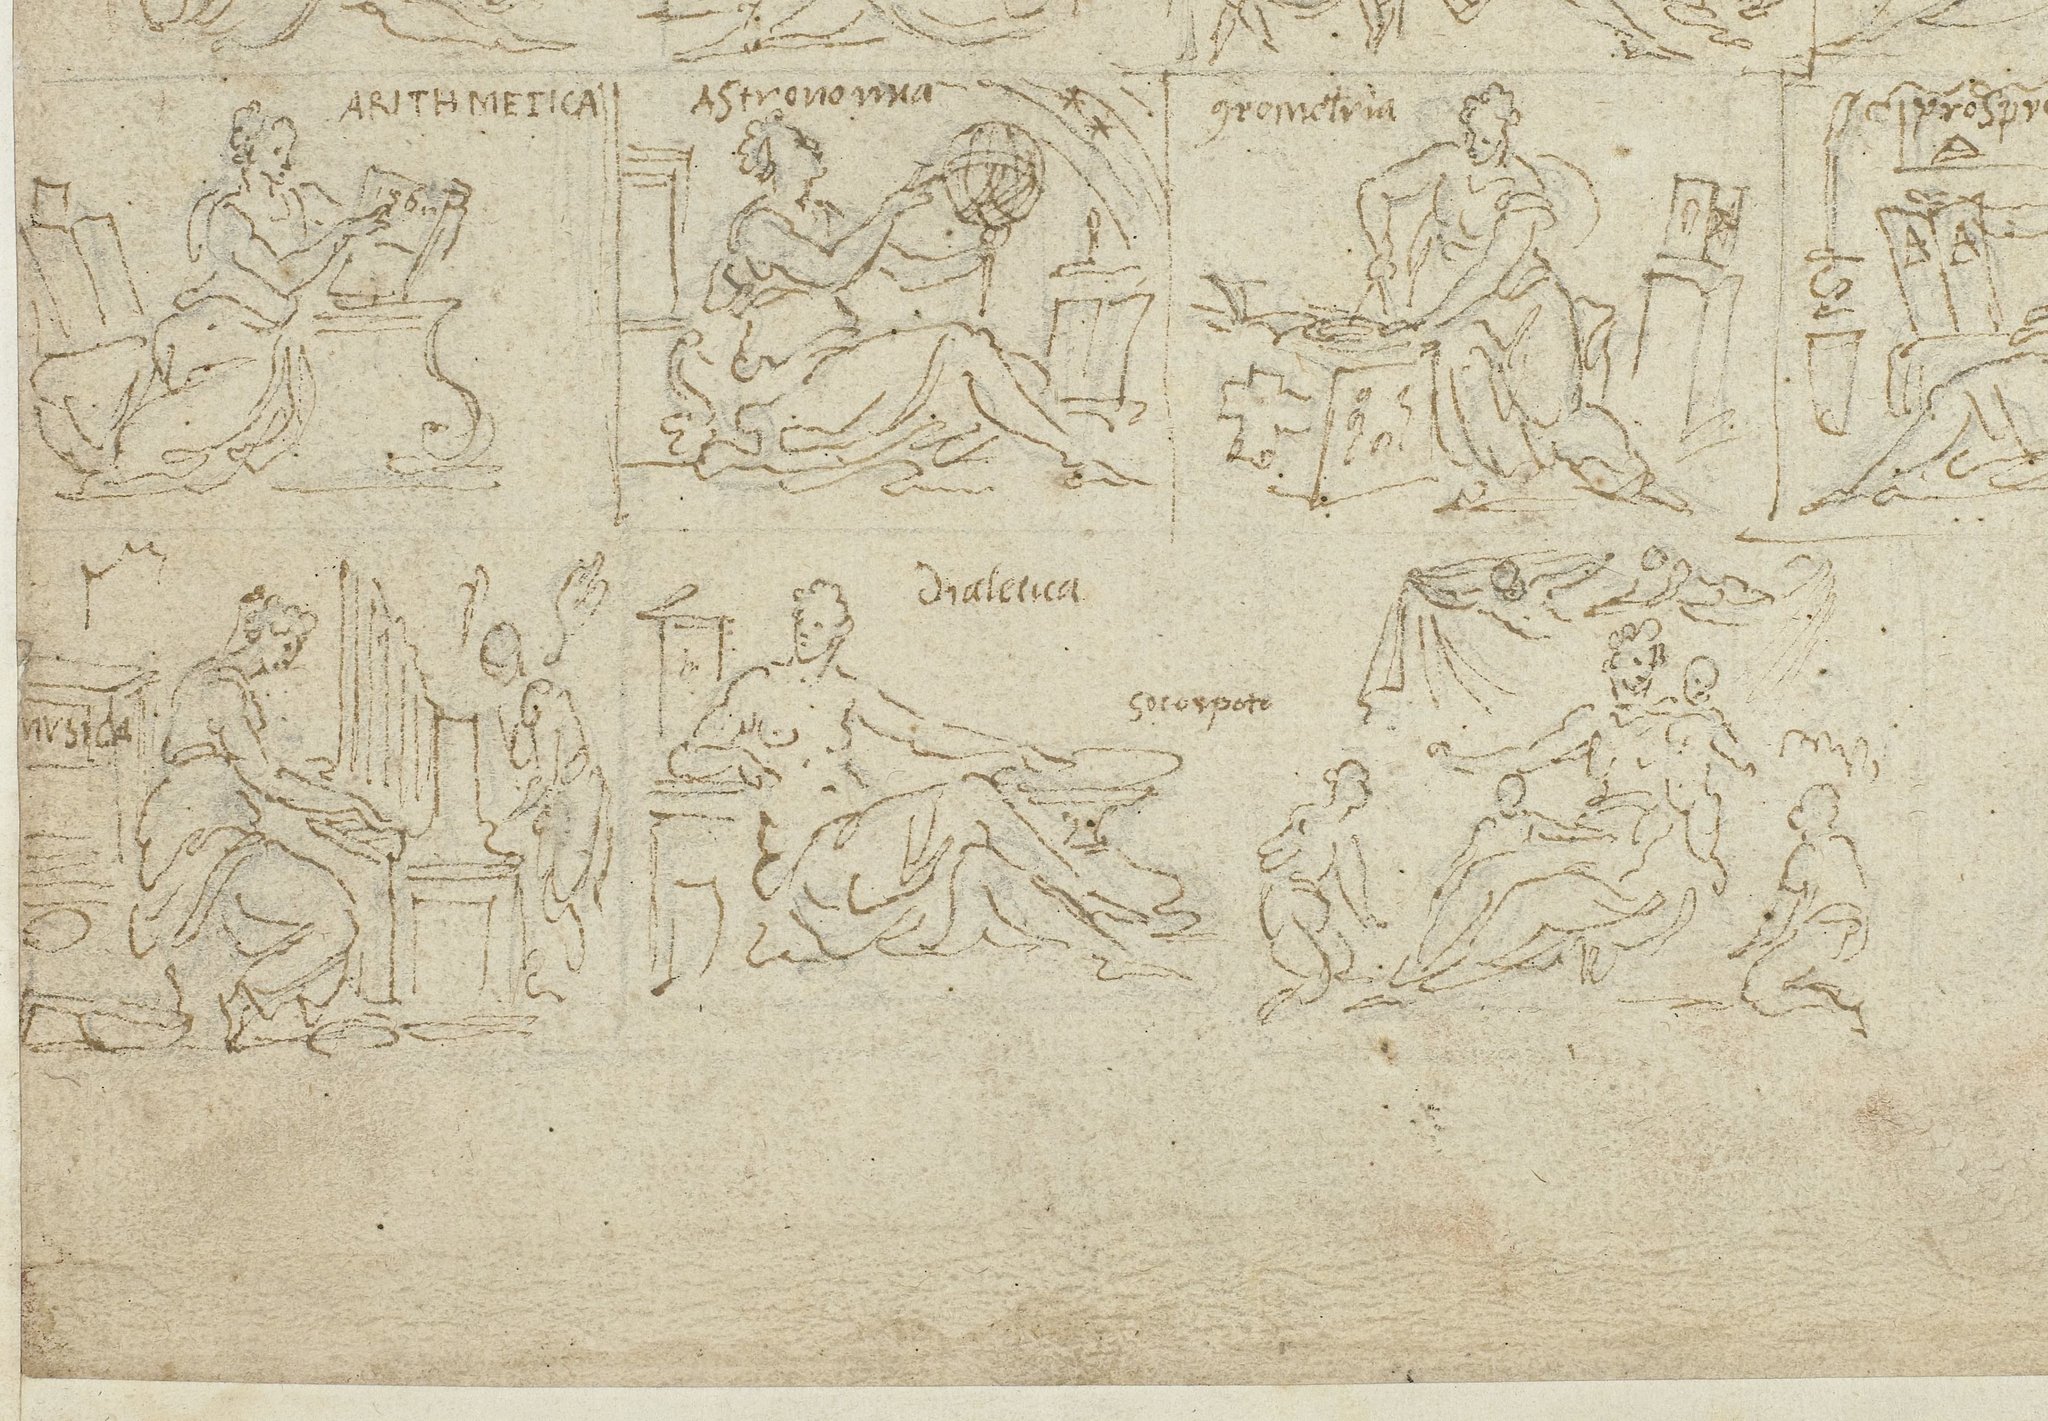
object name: kopie naar tekening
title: De vrije kunsten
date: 1550-1570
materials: chalk, ink, paper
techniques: pen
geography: low countries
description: Album "Maarten de Vos schetsboek", blad 3r(12)